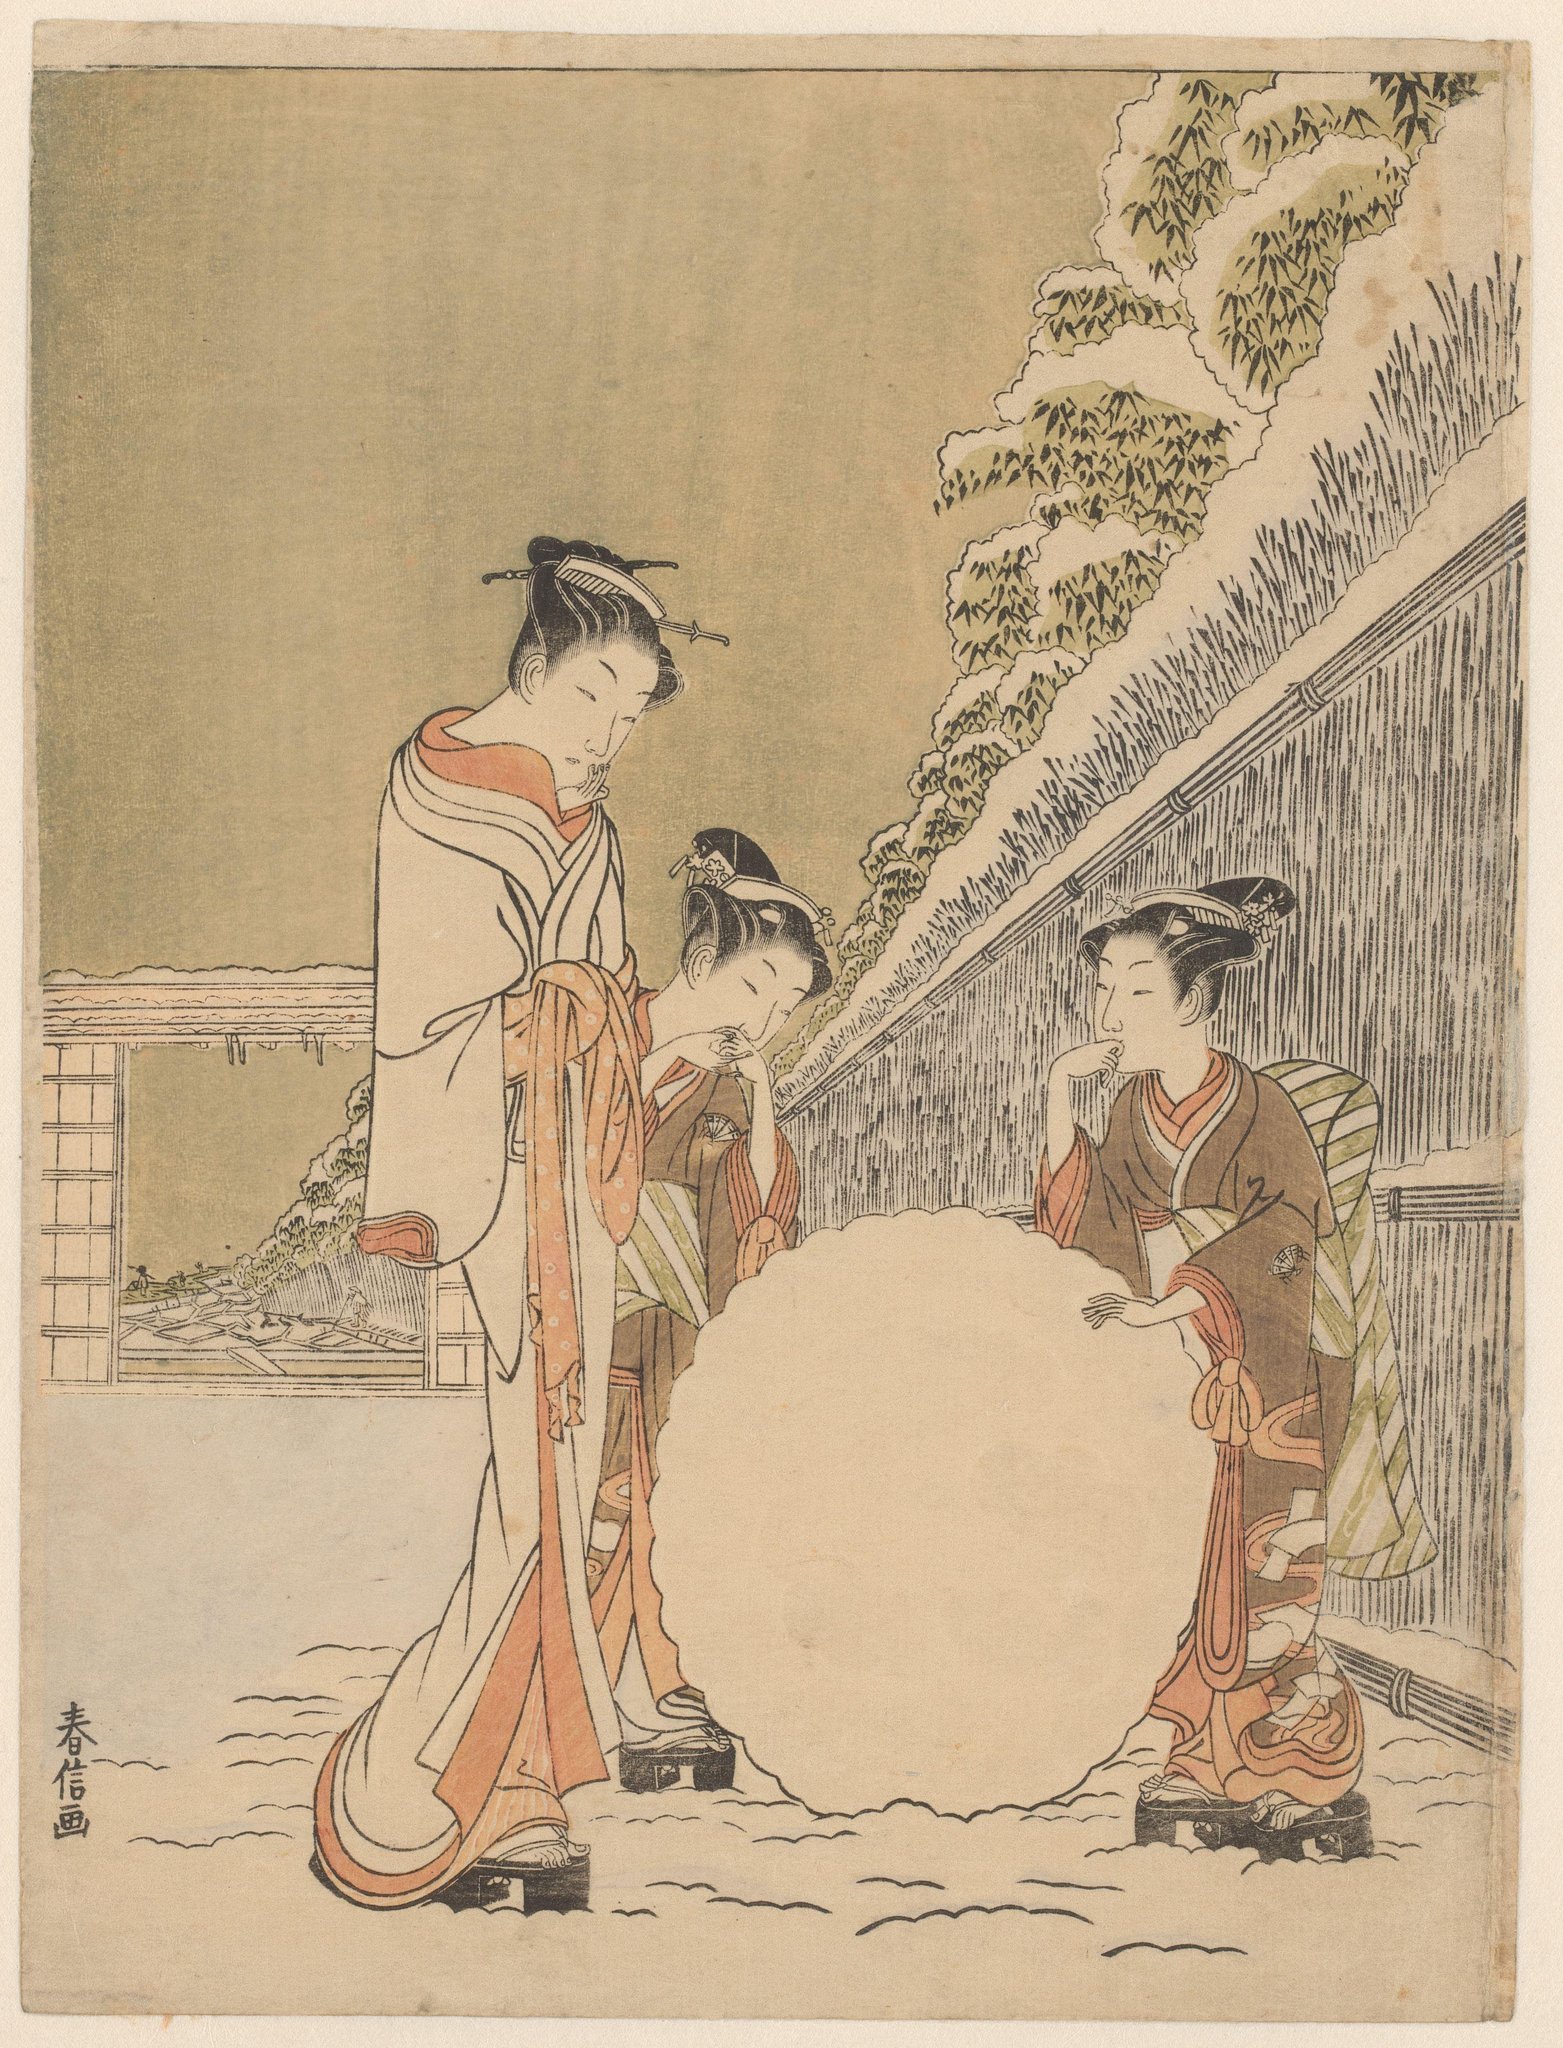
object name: print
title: Courtesan watching her maids roll a snowball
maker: shiba kôkan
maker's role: print maker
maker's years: 1747-1818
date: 1770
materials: paper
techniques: woodcut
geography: japan